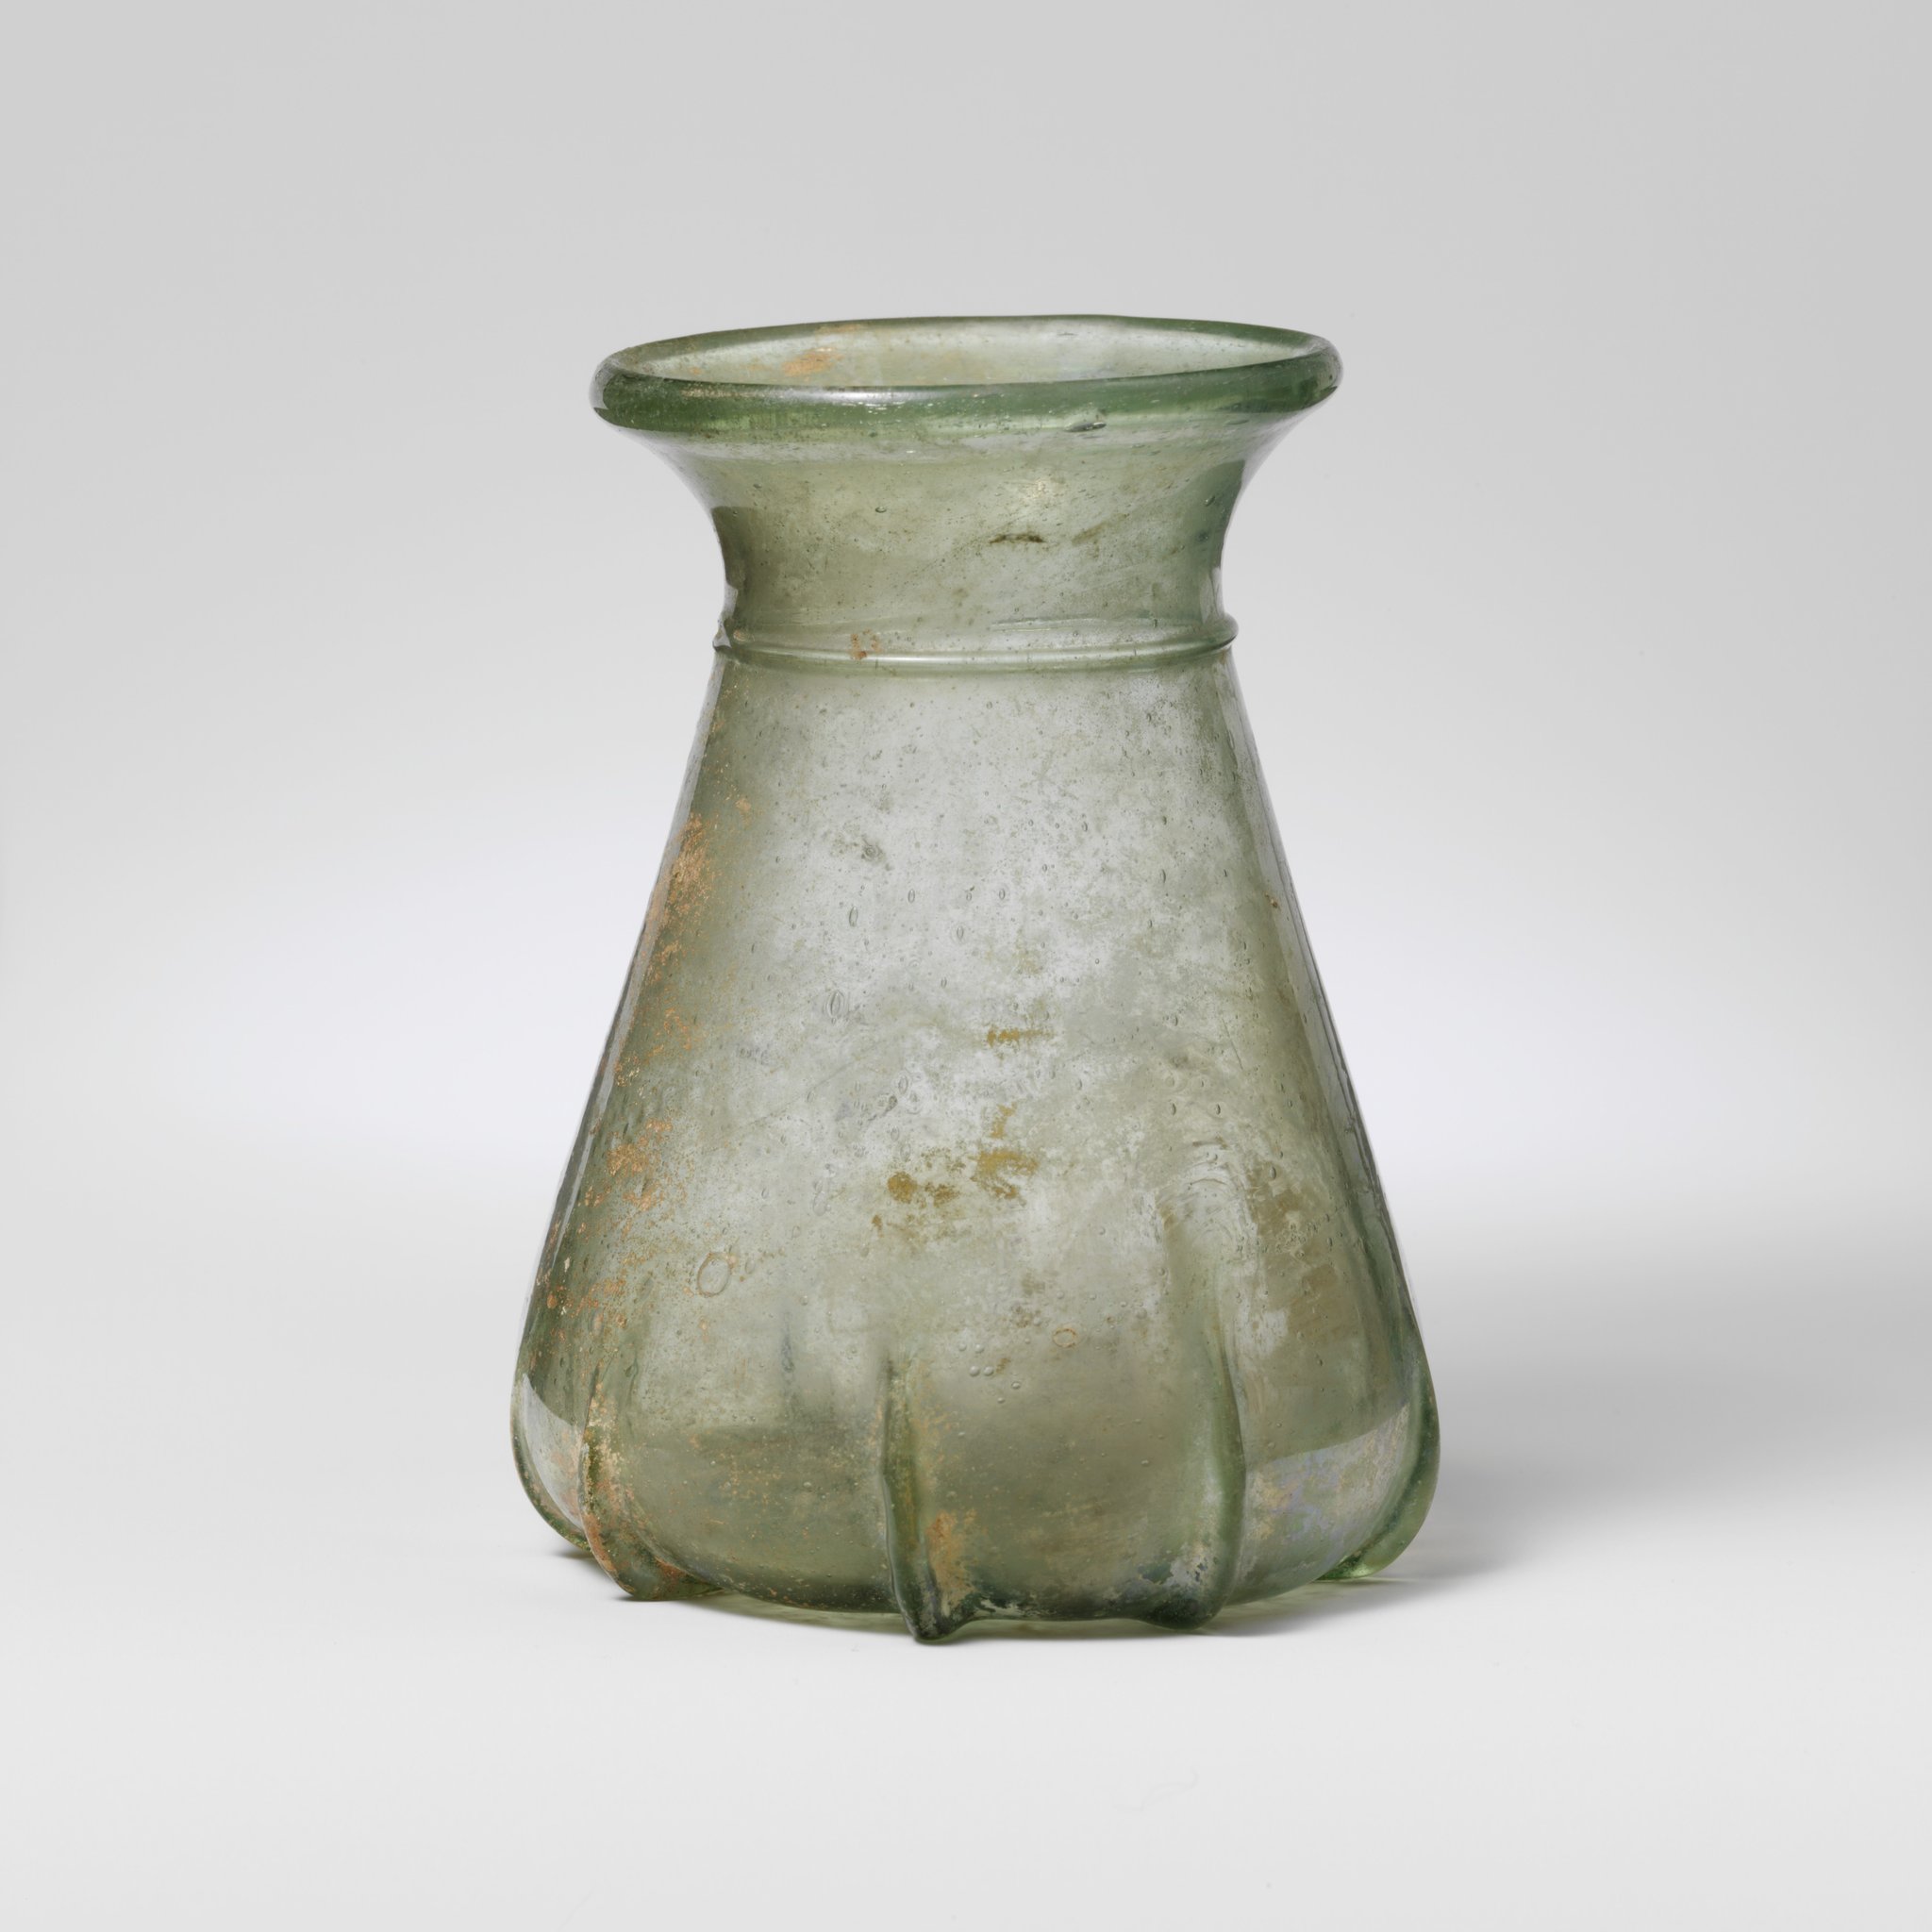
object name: jar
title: Glass jar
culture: roman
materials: glass